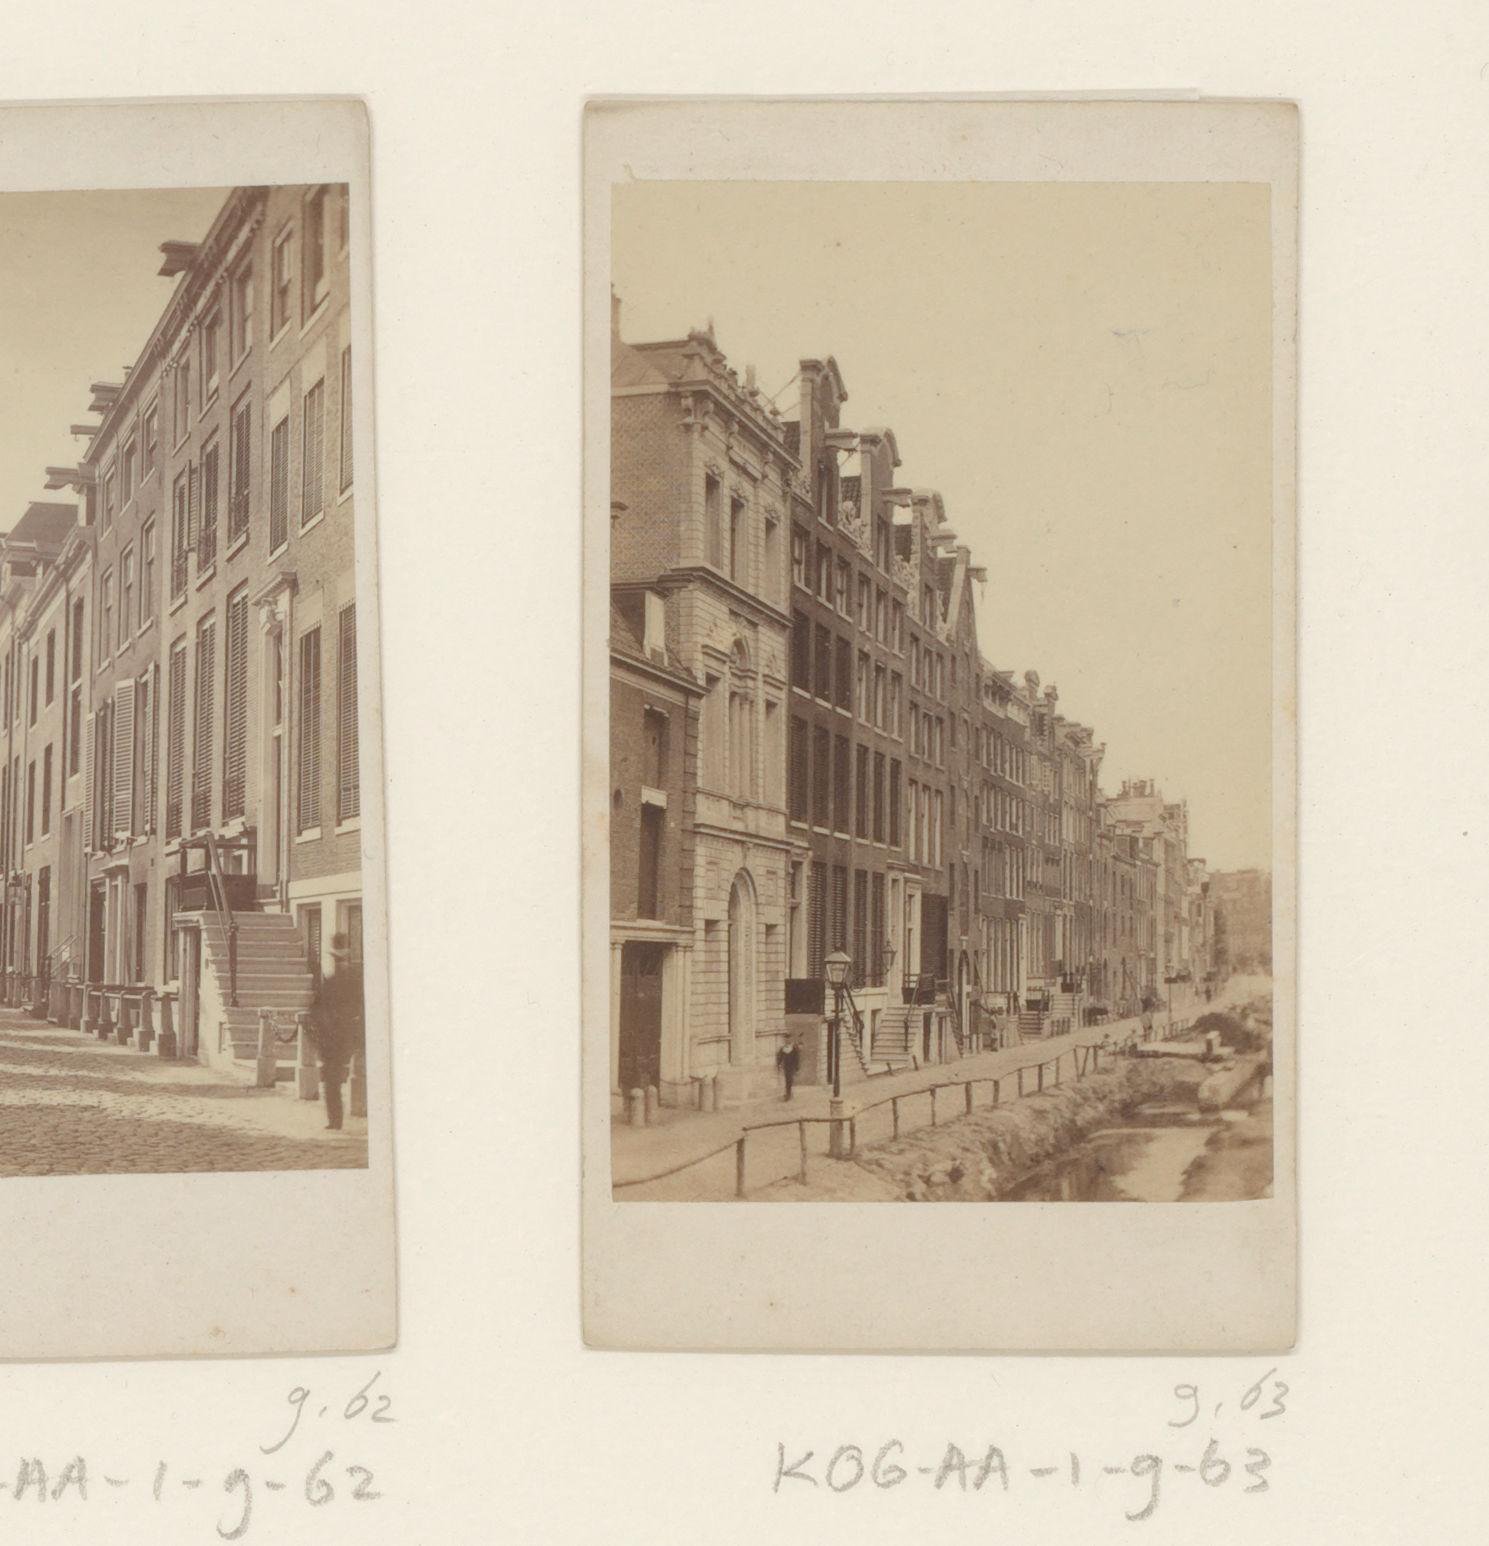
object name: carte de visite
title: Gezicht op de Keizersgracht bij de Vijzelstraat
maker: andries jager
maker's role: publisher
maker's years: 1825-1905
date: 1849-1885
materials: cardboard, paper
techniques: albumen print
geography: amsterdam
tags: city-view in general; 'veduta', canal, the usual house or row of houses, street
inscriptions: stamp: ‘A. Jager / Water, 110 / Amsterdam’, collector's mark: ‘9.63’ Lugt 1641b, inscription: ‘4. Het Museum Fodor. / Keizersgracht / b/d Vijzelstraat’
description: Onderwerpsrubriek binnen de Atlas Amsterdam: Kadijksplein, Karthuizerkerkhof, Kattegat, Kattenburg, Kapelsteeg O.Z., Enge Kerksteeg, Kerkstraat, Kinkerstraat, Kolk O.Z., Koningsplein, Kromboomsloot [Krom Boomssloot], Kostverlorenkade, Kwakersdwarspad, Kalverstraat, Keizersgracht (v.d. Brouwersgracht – Amstel), Klerensloot (Gedempte), Klimopstraat, Kloveniersburgwal, Kraansluis.